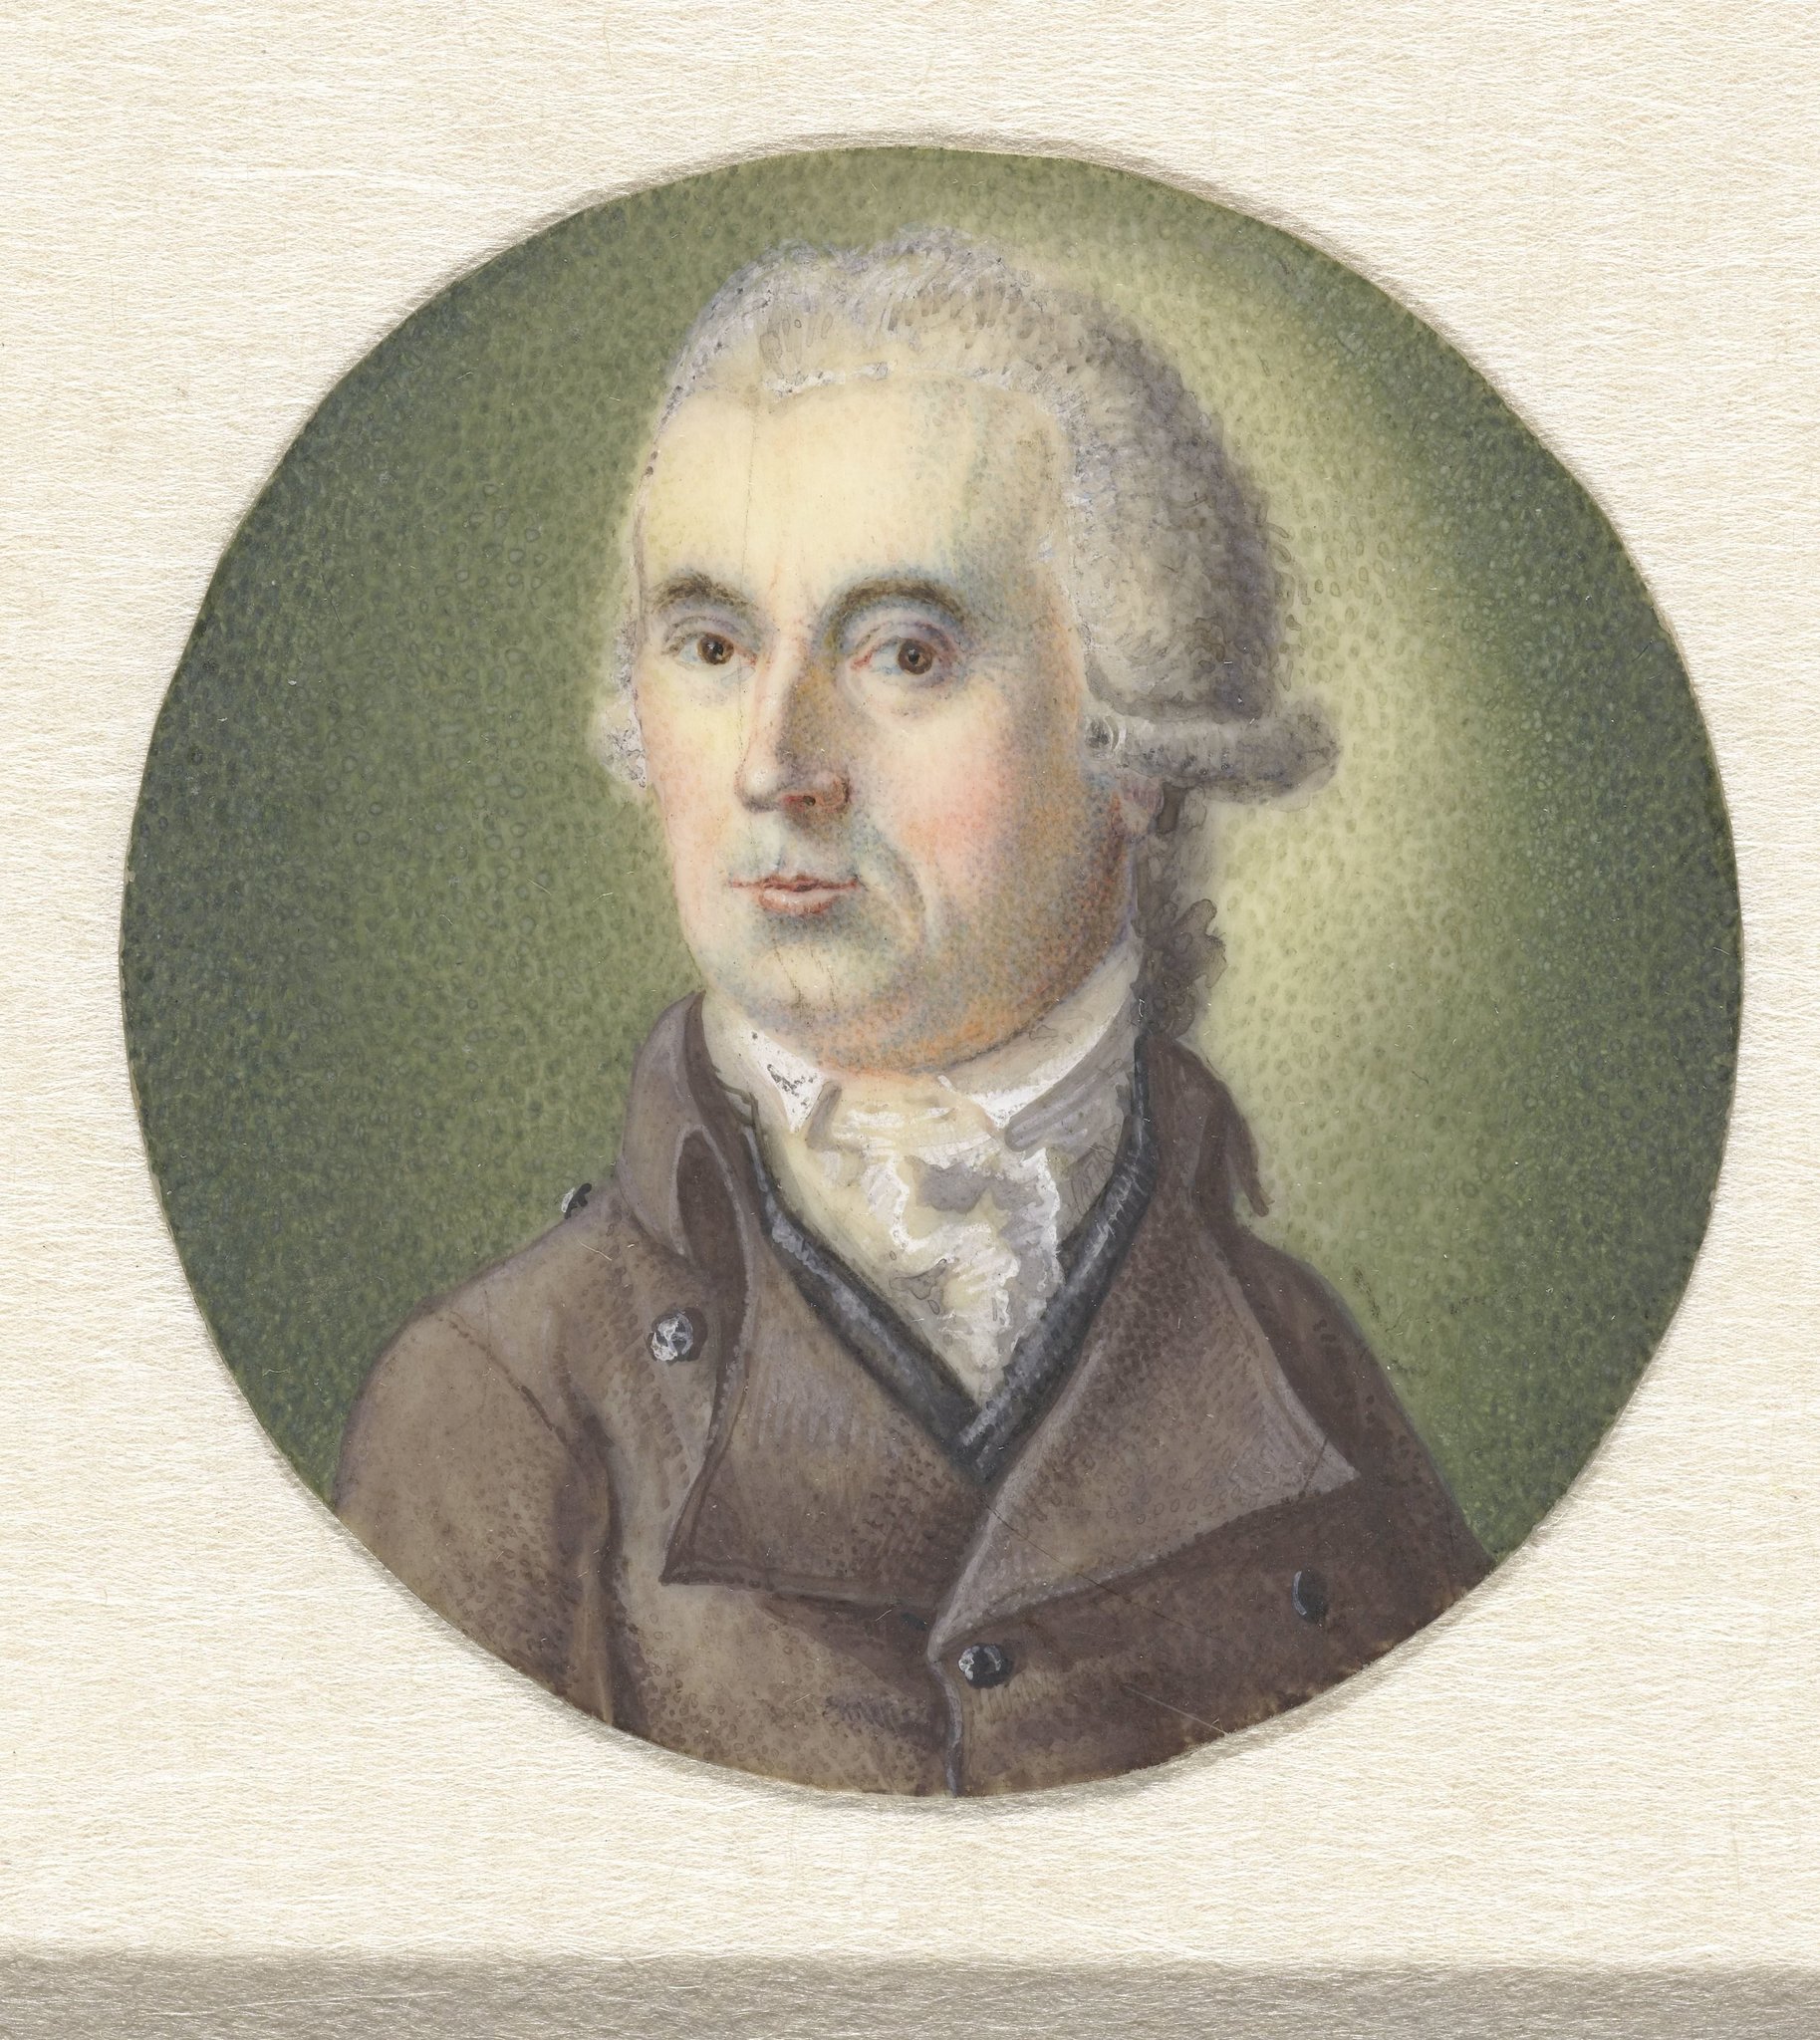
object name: drawing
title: Portret van Jan van Os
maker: pieter gerardus van os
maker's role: draughtsman, painter, print maker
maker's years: 1776-1839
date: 1786-1839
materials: paint, gouache, ivory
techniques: brush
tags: jan van os, historical persons, portrait, self-portrait of artist, portrait, self-portrait of draughtsman